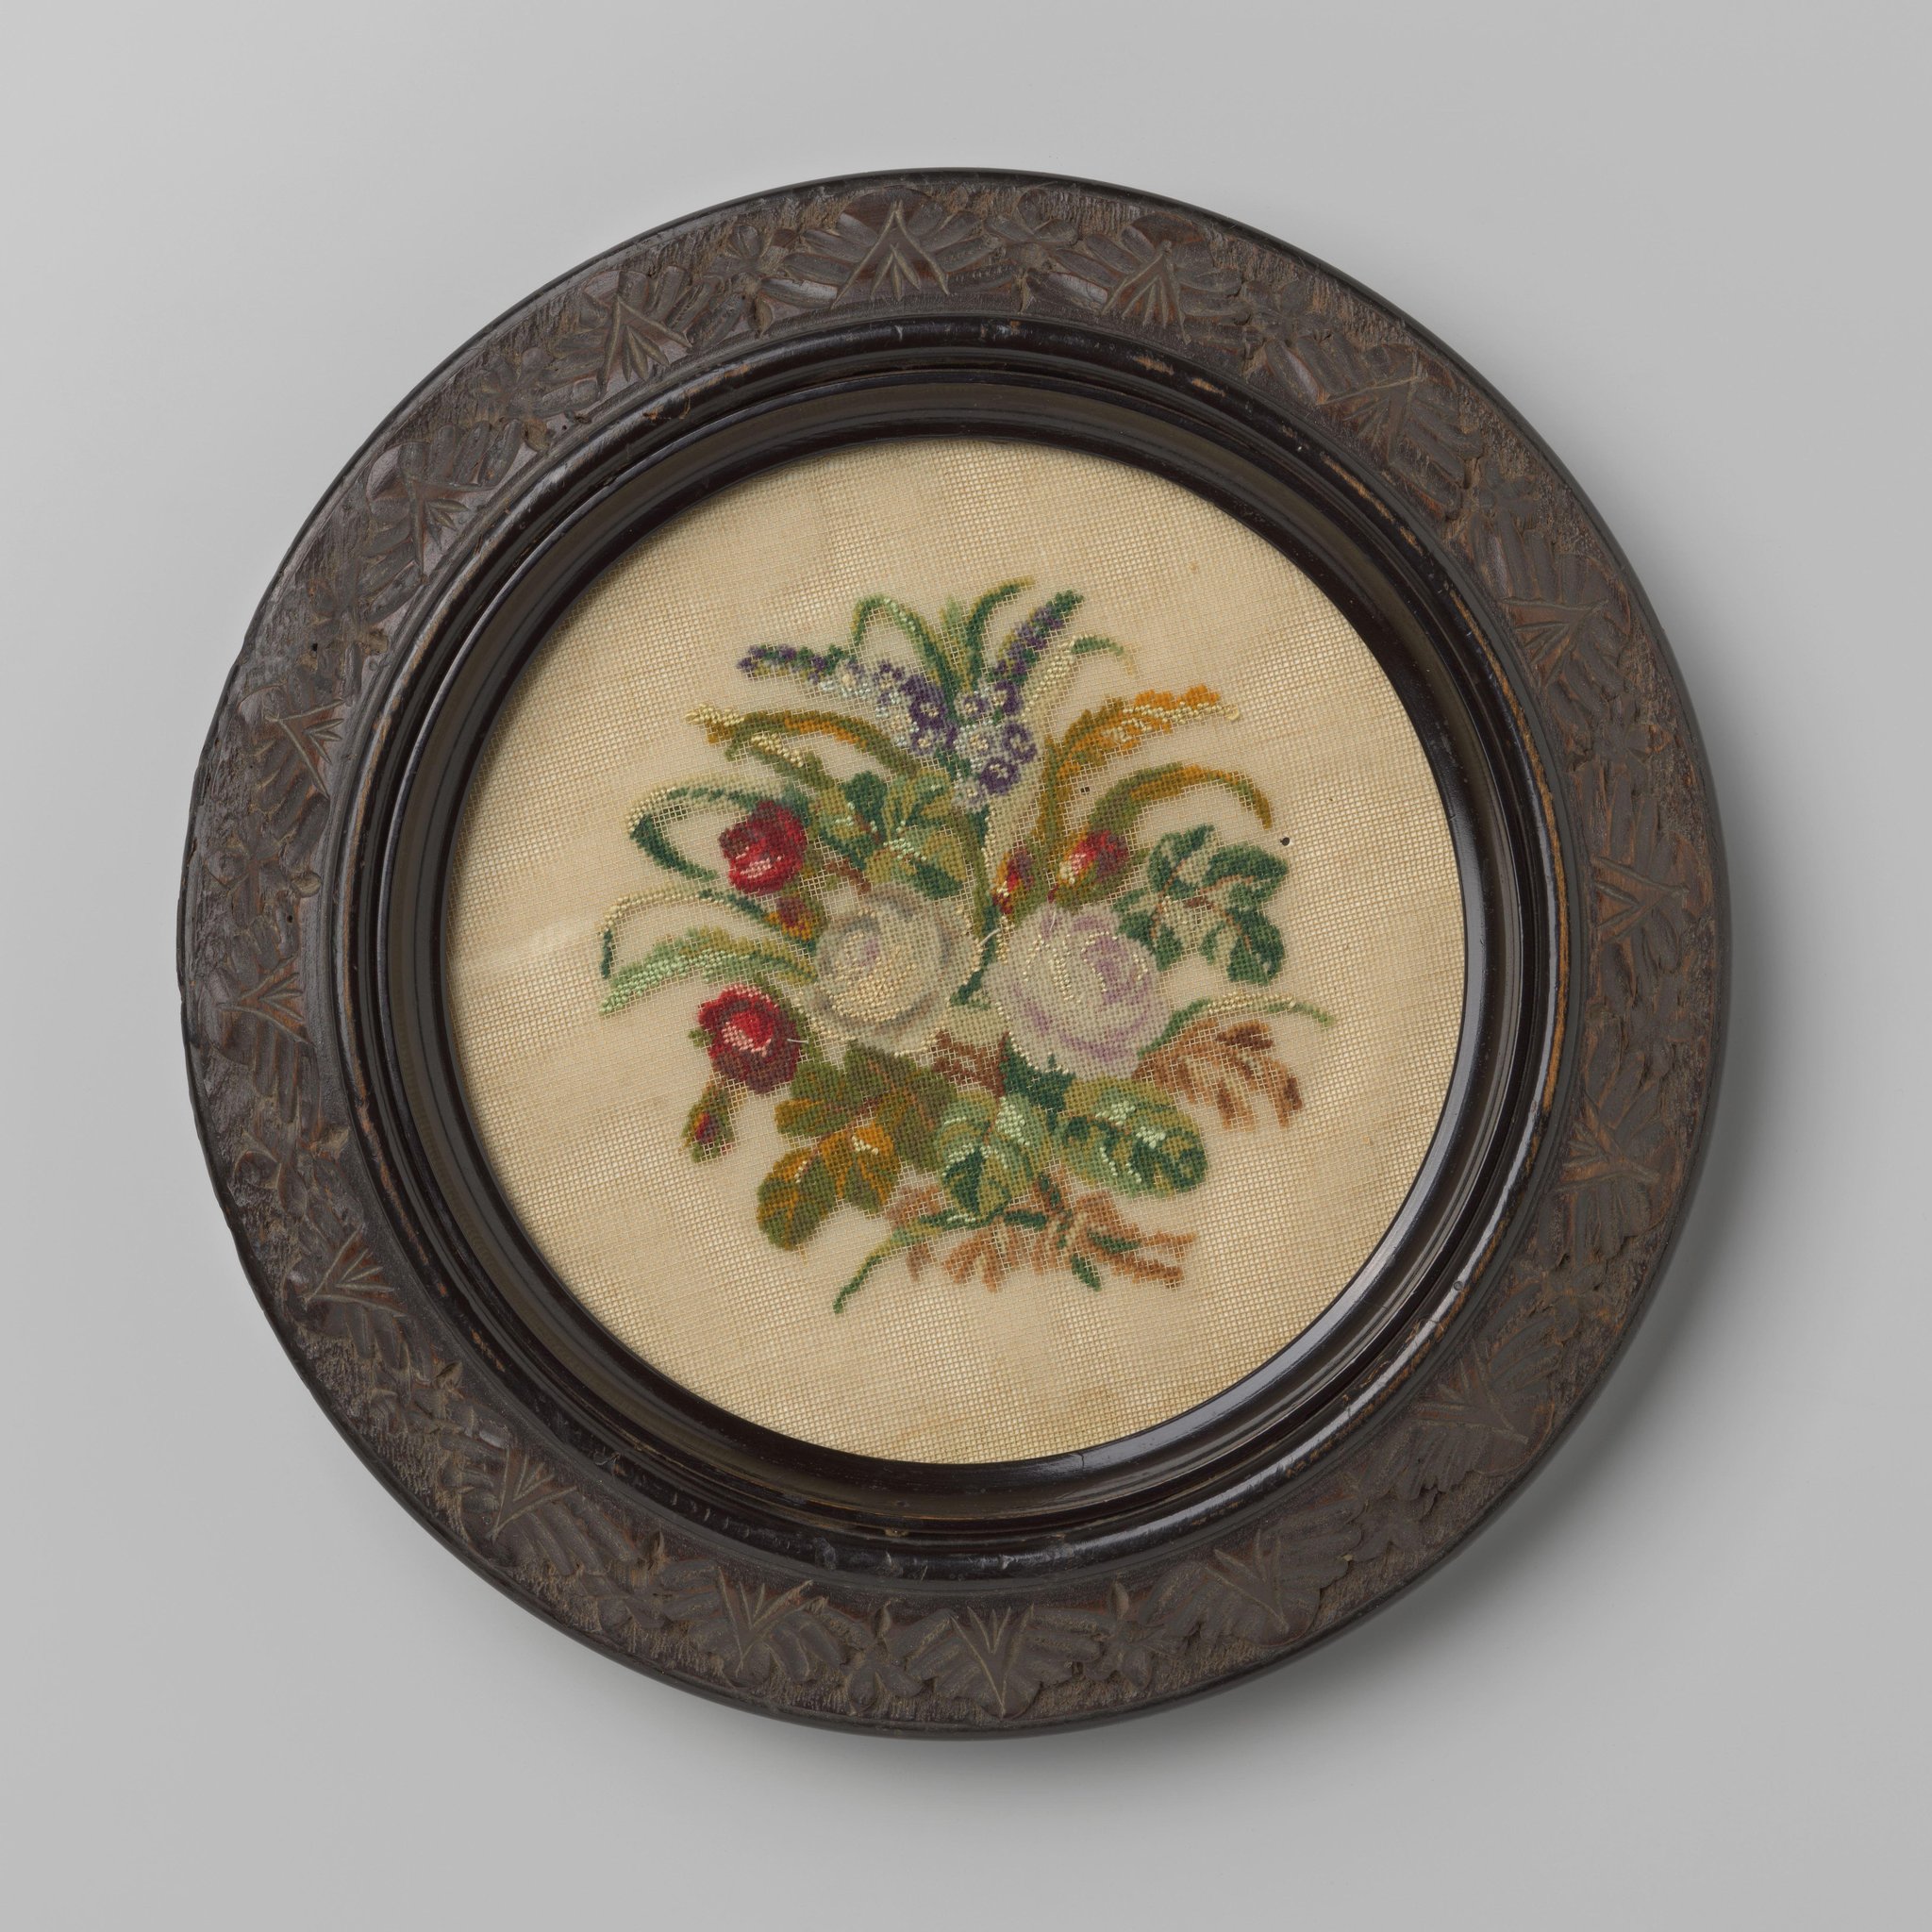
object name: console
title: Bloempotconsole met borduurwerk in petit-point van rozen, rozenknoppen en vergeet-mij-nietjes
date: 1870-1880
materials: cotton, linen, silk, wood, wool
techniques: embroidered, petit point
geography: netherlands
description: Bloempotconsole met borduurwerk in petit-point op stramien, in wol en hier en daar gehoogd met zijde. Patroon: een boeket van vier rozen, enige rozenknopjes en takjes vergeet-mij-nietjes op grond van onbewerkte stramien. Eén van de rozen is donkerrood, de andere zijn lila.